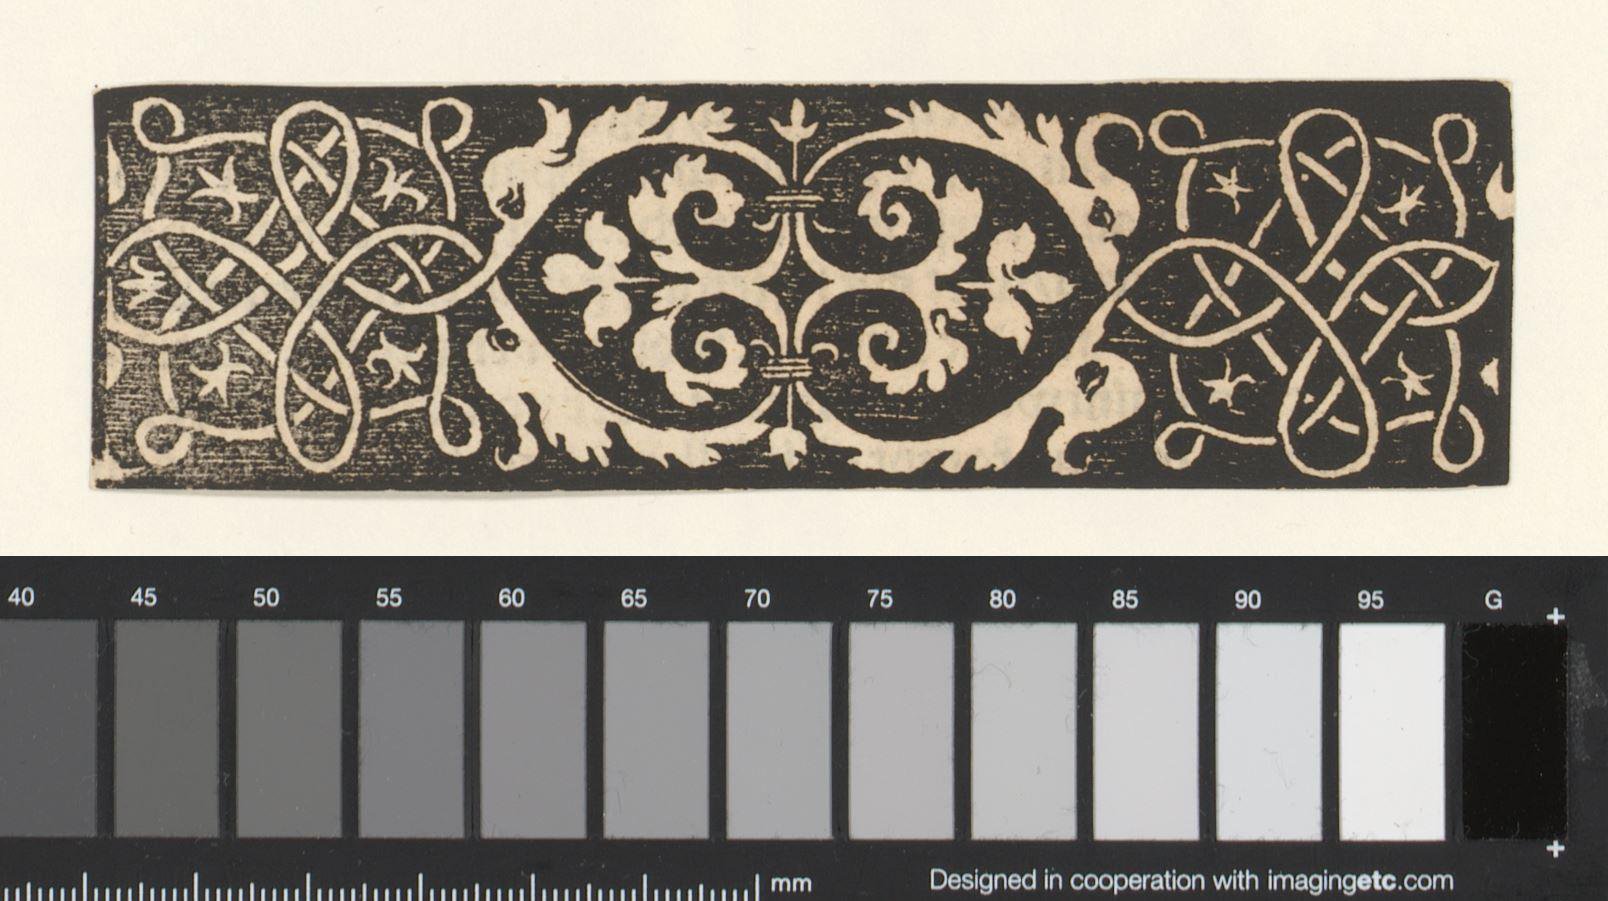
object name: print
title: Ornament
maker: Anonymous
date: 1514-1532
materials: paper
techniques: letterpress printing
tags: foliage ~ ornament, ornament ~ round and curved forms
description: Deze prent is gebruikt als ornament in: Petrarca, Francesco. Von der Artzney bayder Glück, des guten und widerwertigen: unnd weß sich ain yeder inn Gelück und Unglück halten sol (...). Augsburg: Heinrich Steiner, 1532. Deze uitgave is ook bekend onder de titel 'Trostspiegel in Glück und Unglück'.